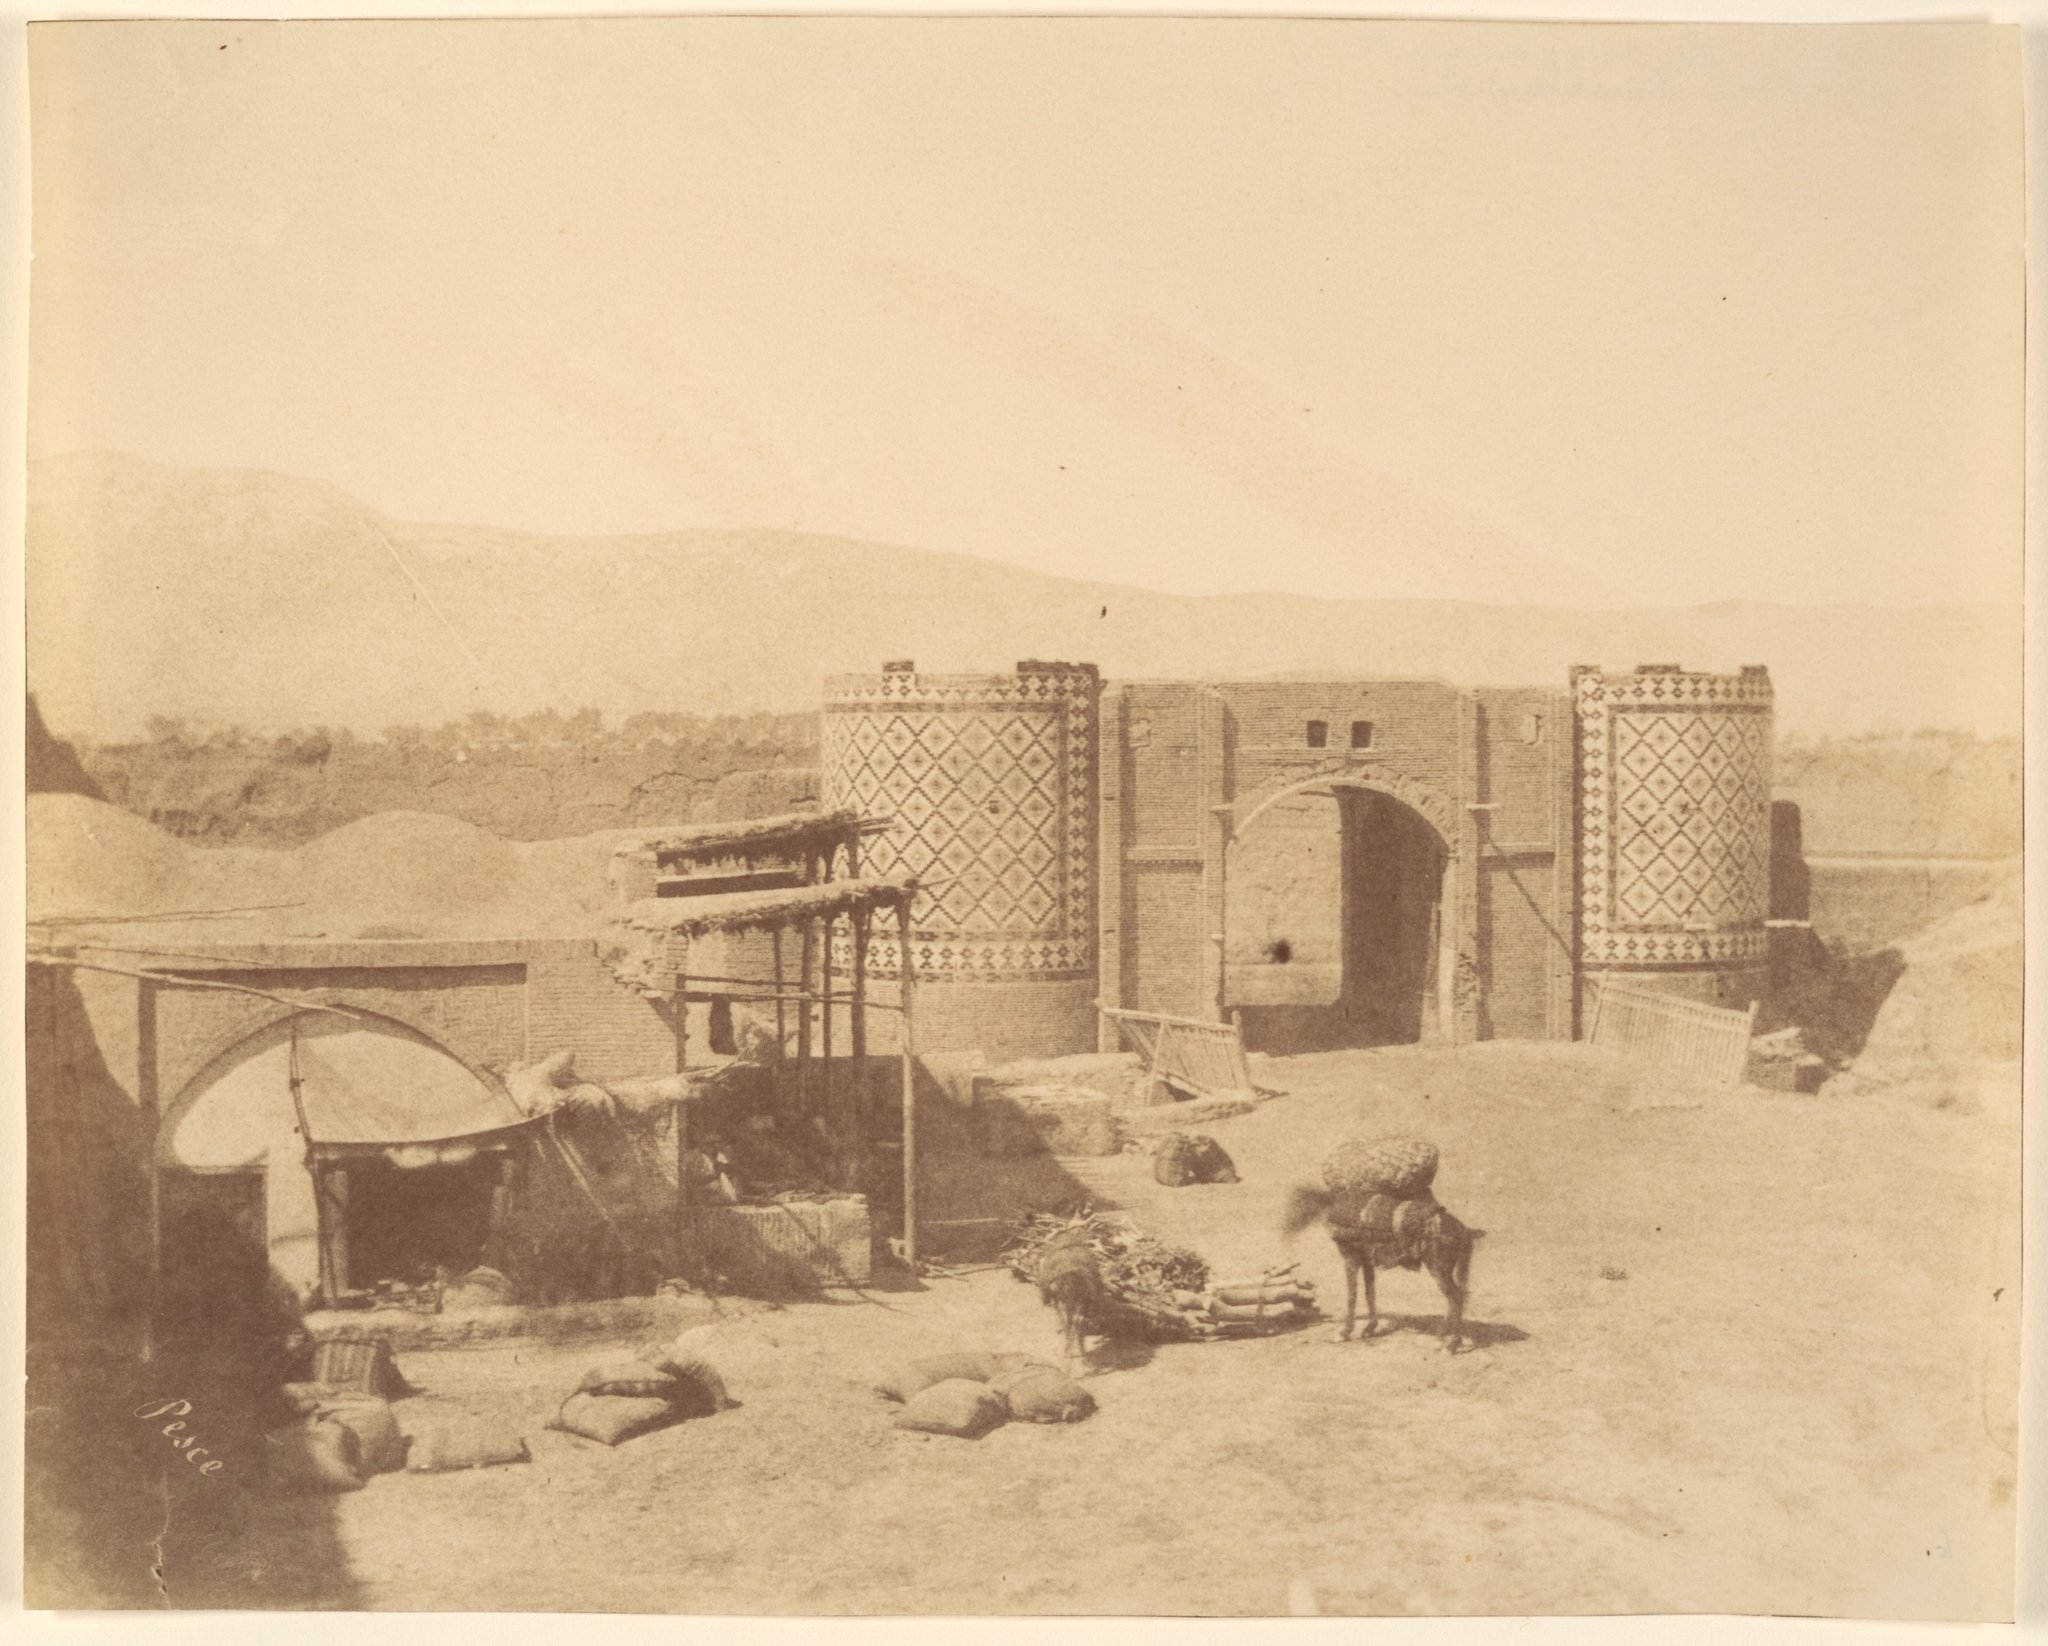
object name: photograph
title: [Gate of Government, Teheran, Iran]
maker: luigi pesce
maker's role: artist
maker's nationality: italian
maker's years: 1818-1891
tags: architecture,gates